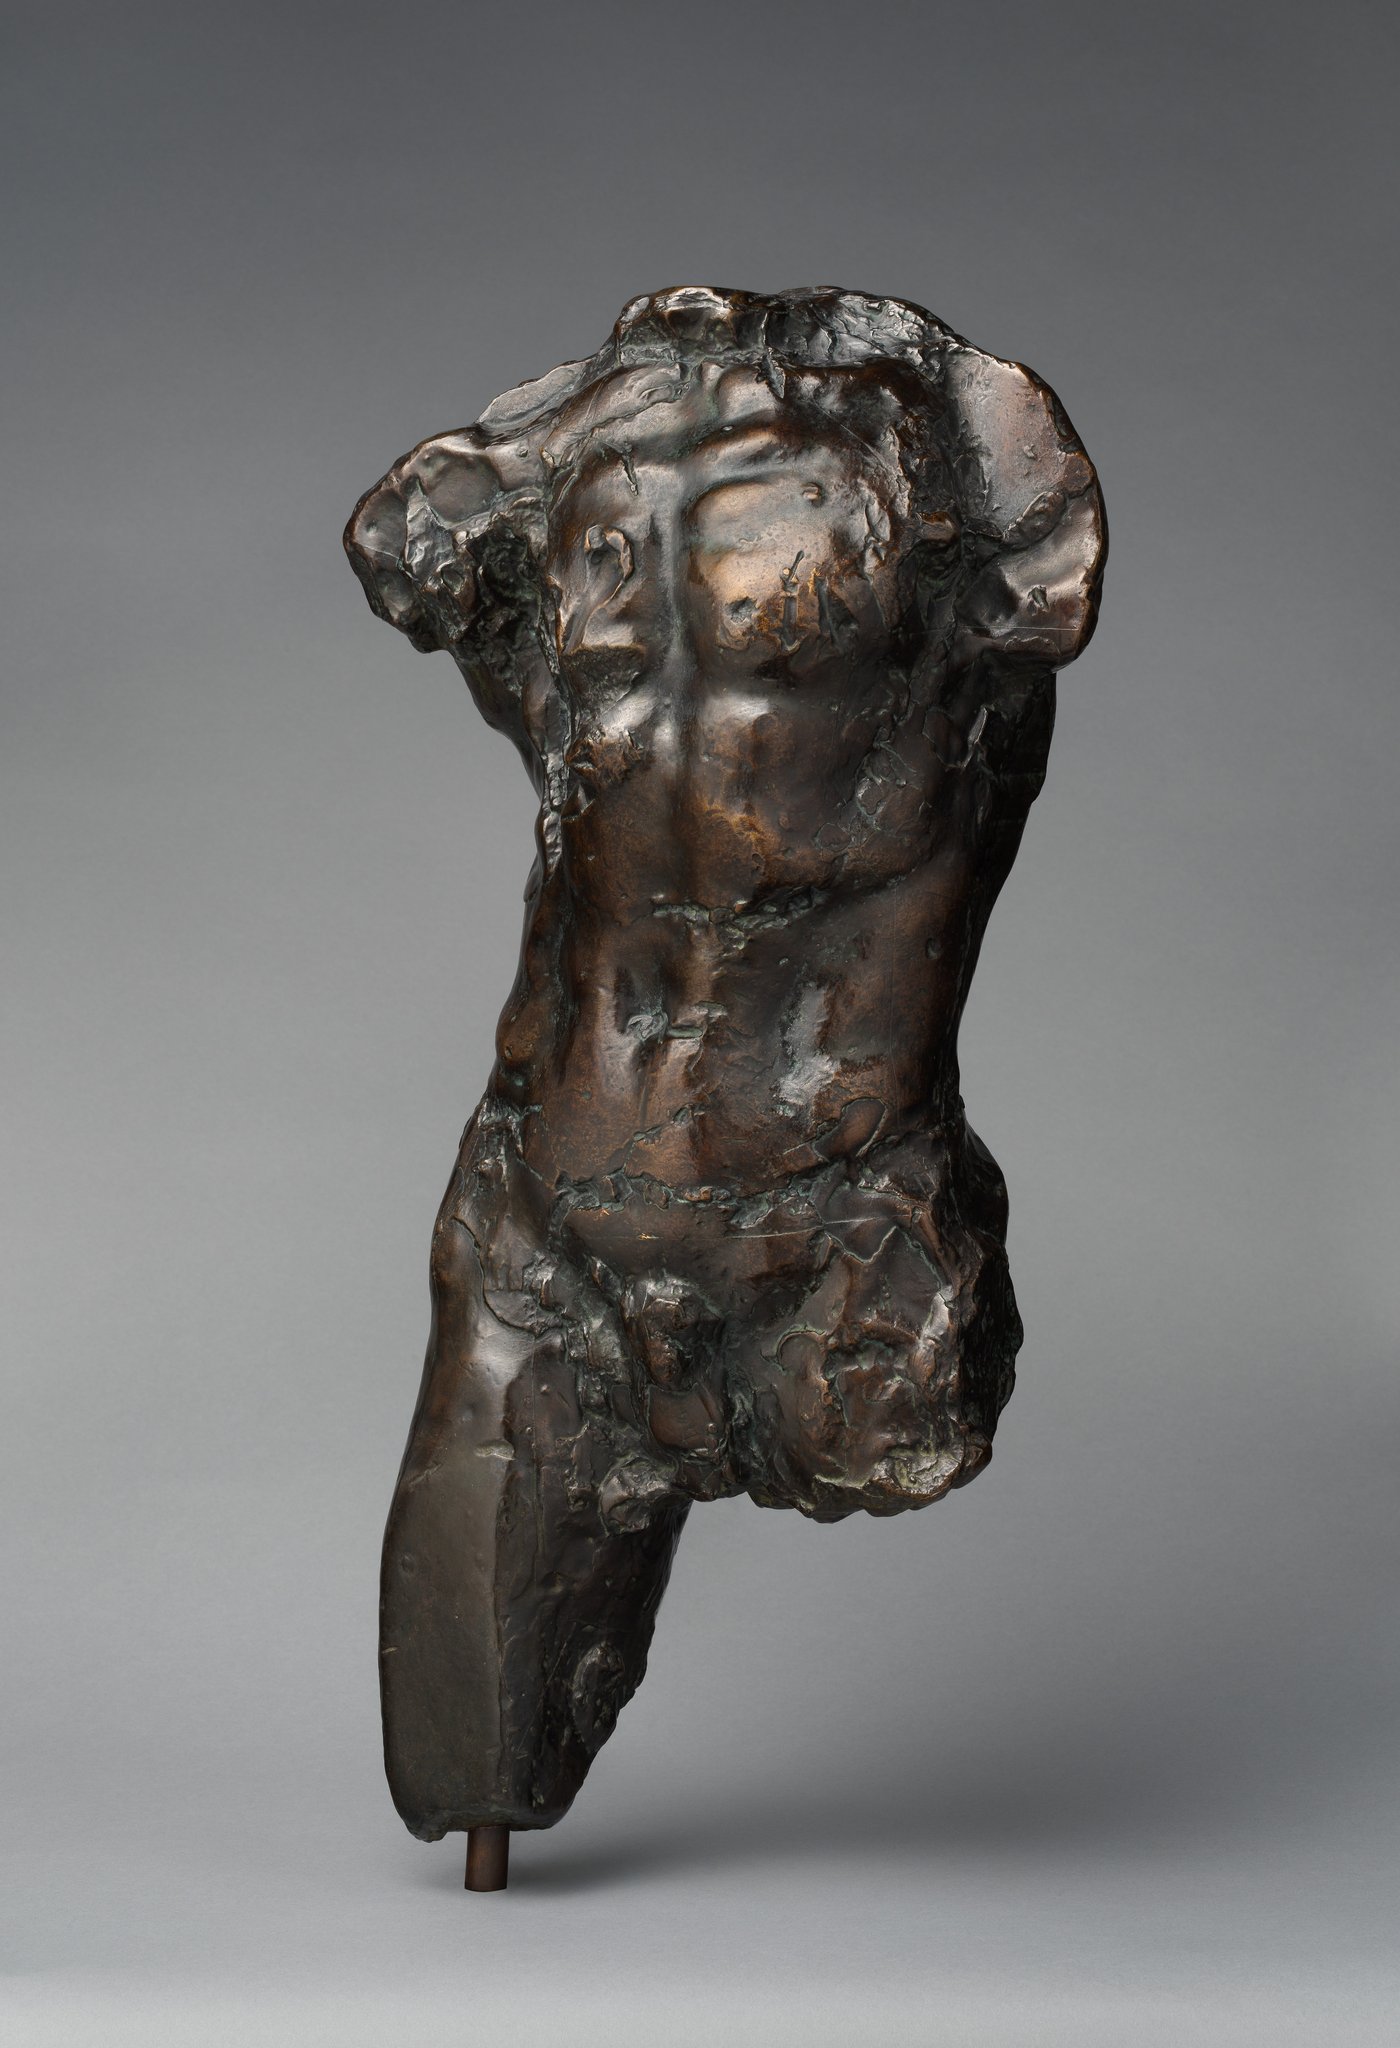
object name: torso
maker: auguste rodin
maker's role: artist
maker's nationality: french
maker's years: 1840-1917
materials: bronze, marble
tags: hands,male nudes